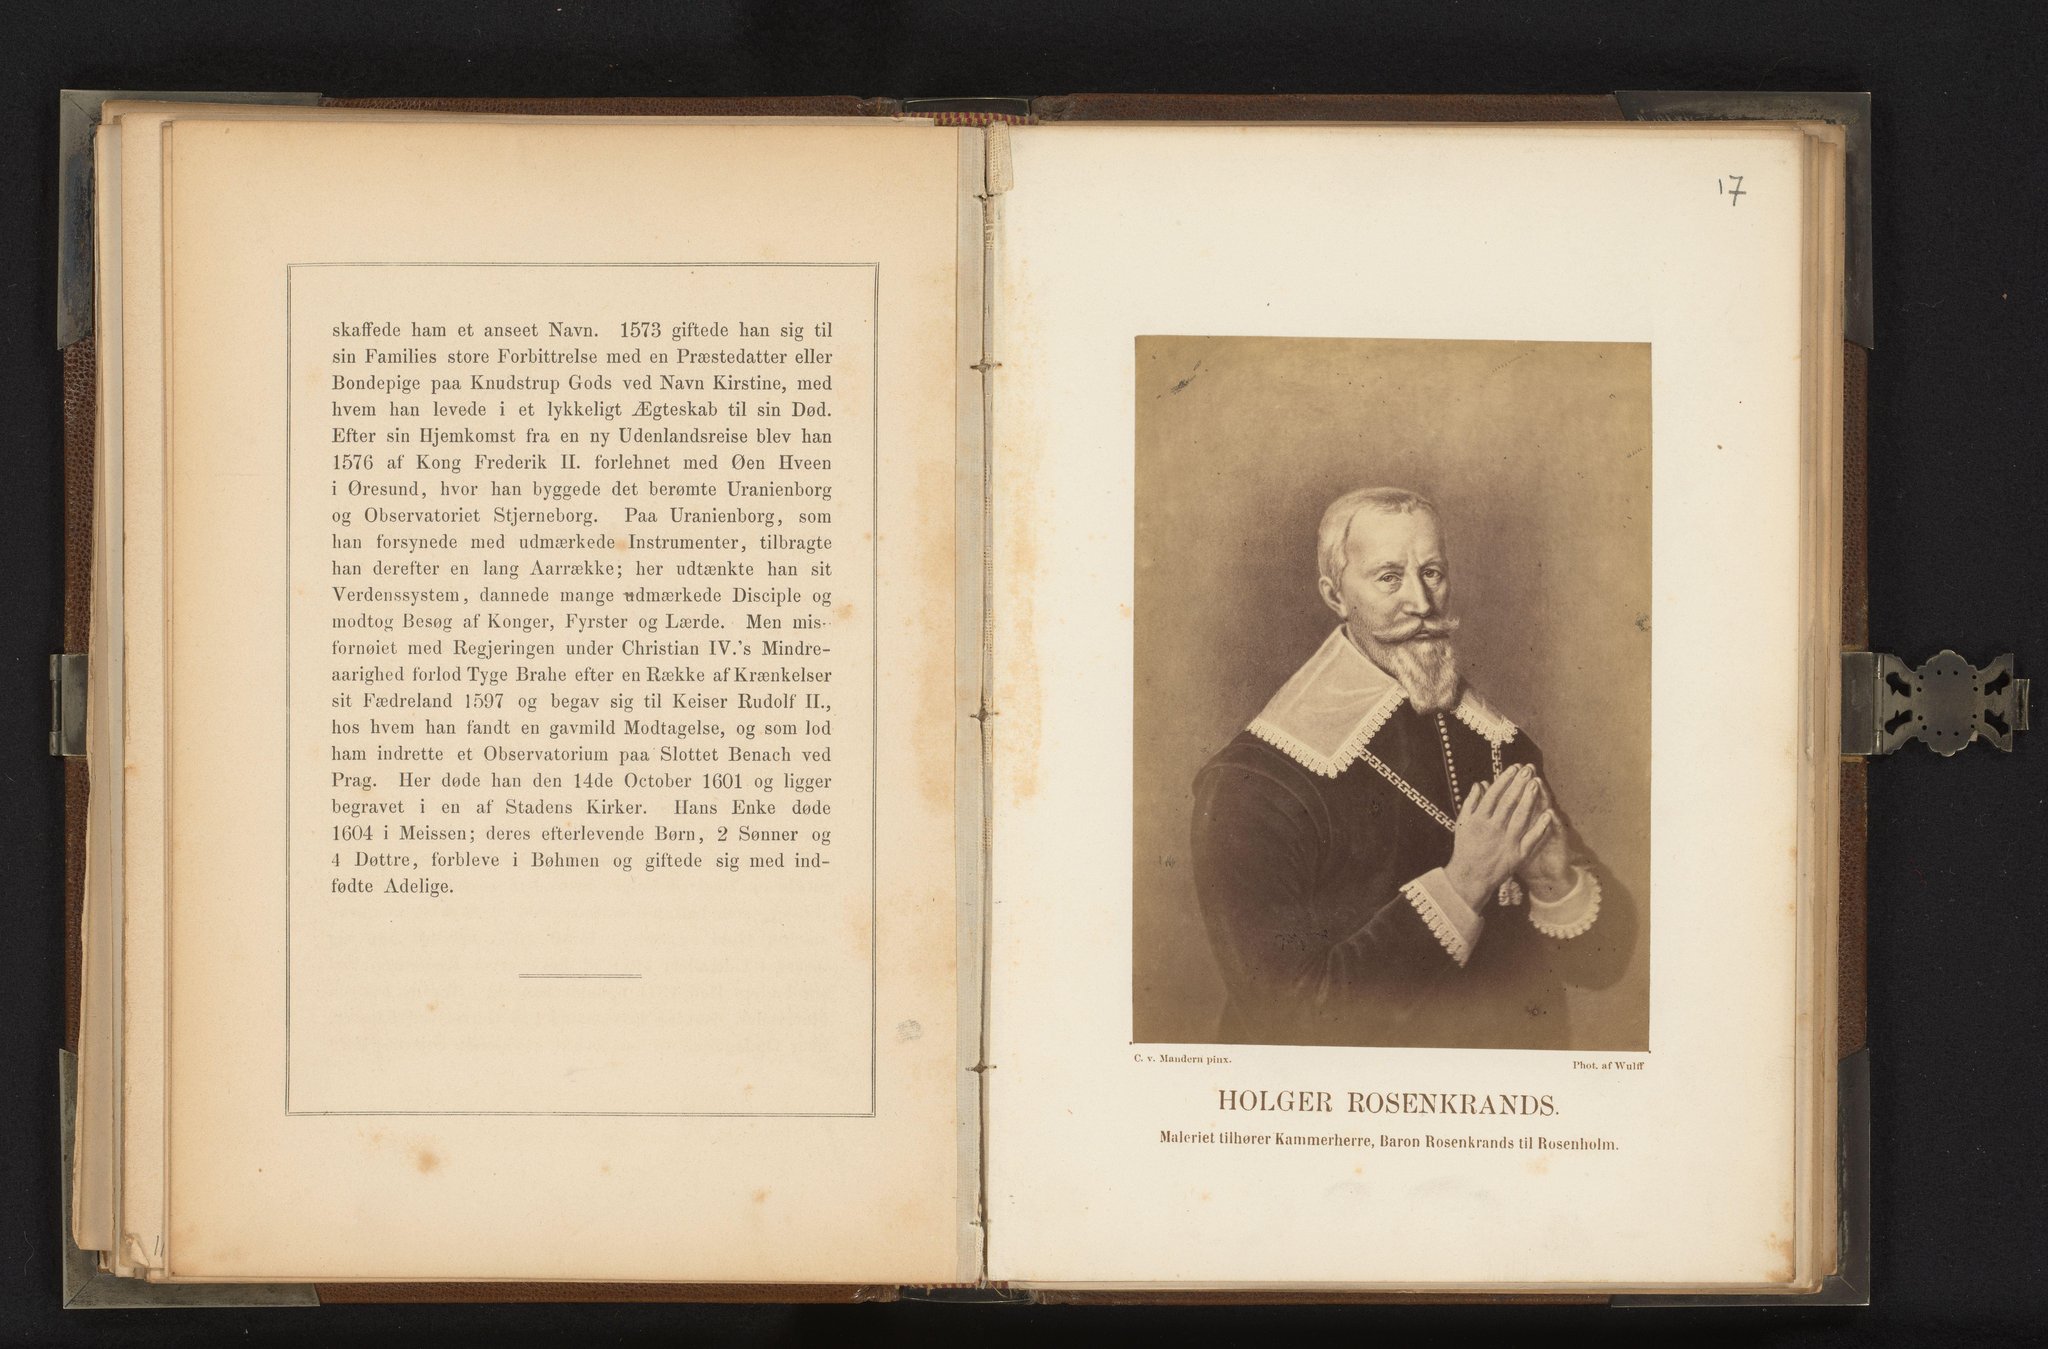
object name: page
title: Holger Rosenkrands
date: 1858-1863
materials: photographic support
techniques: albumen print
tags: disputing theologians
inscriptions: inscription: ‘Maleriet tillhører Kammerherre, Baron Rosenkrands till Rosenholm.’